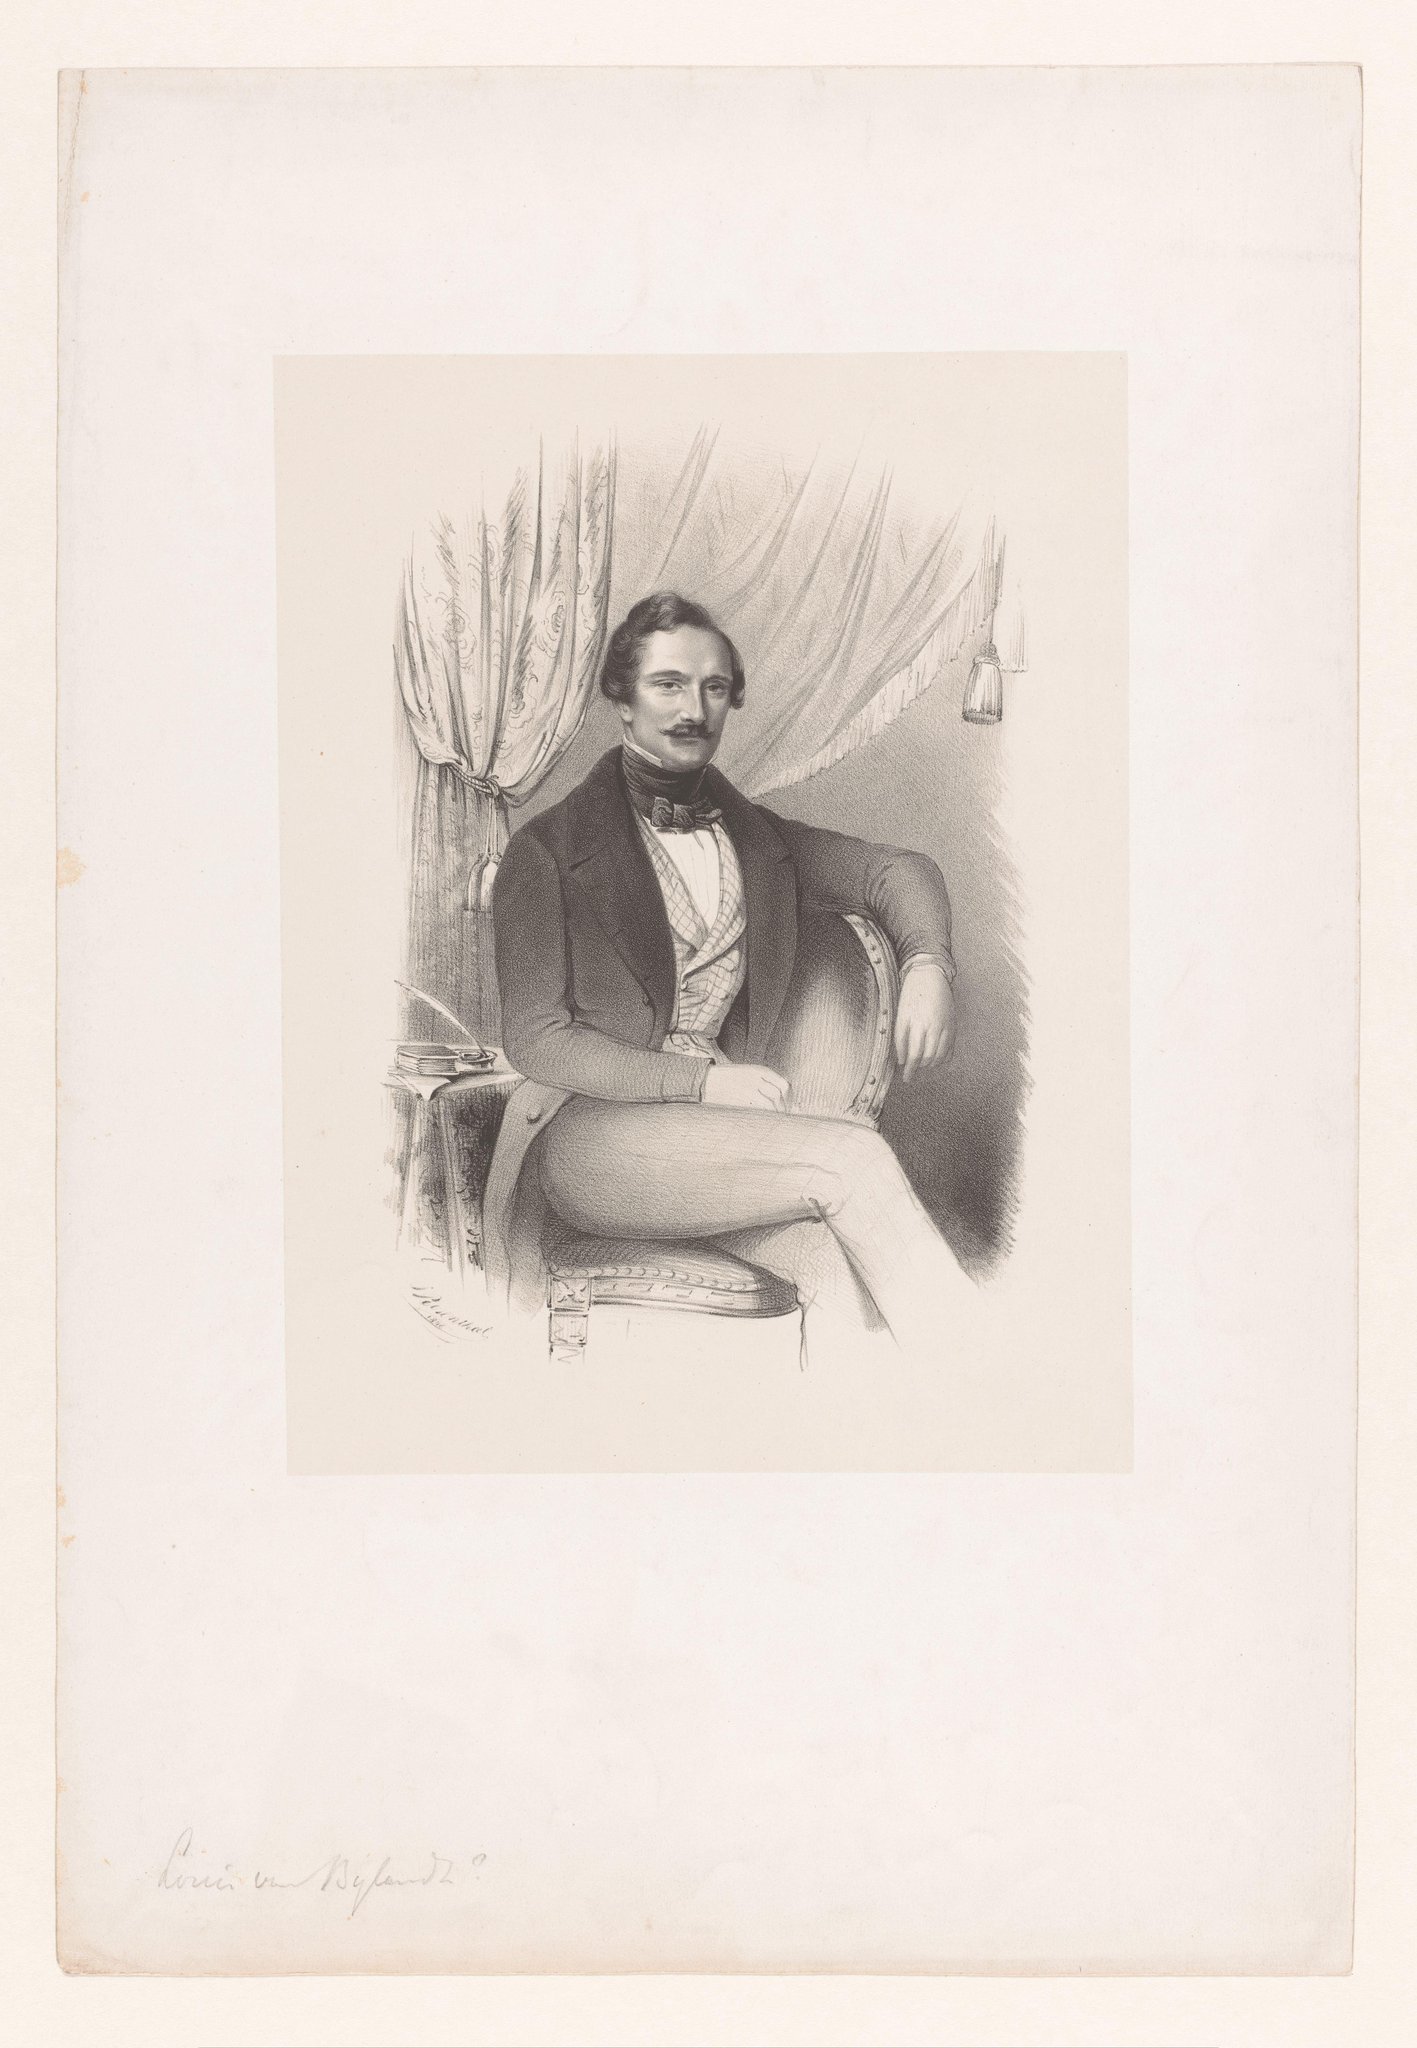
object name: print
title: Portret van onbekende man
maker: s. rosenthal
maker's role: print maker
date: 1846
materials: paper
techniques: lithograph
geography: netherlands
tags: anonymous historical person portrayed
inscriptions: collector's mark: Lugt 2228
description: Een man zittend op een stoel naast een tafel met boek en schrijfveer. Achter hem hangen gordijnen.